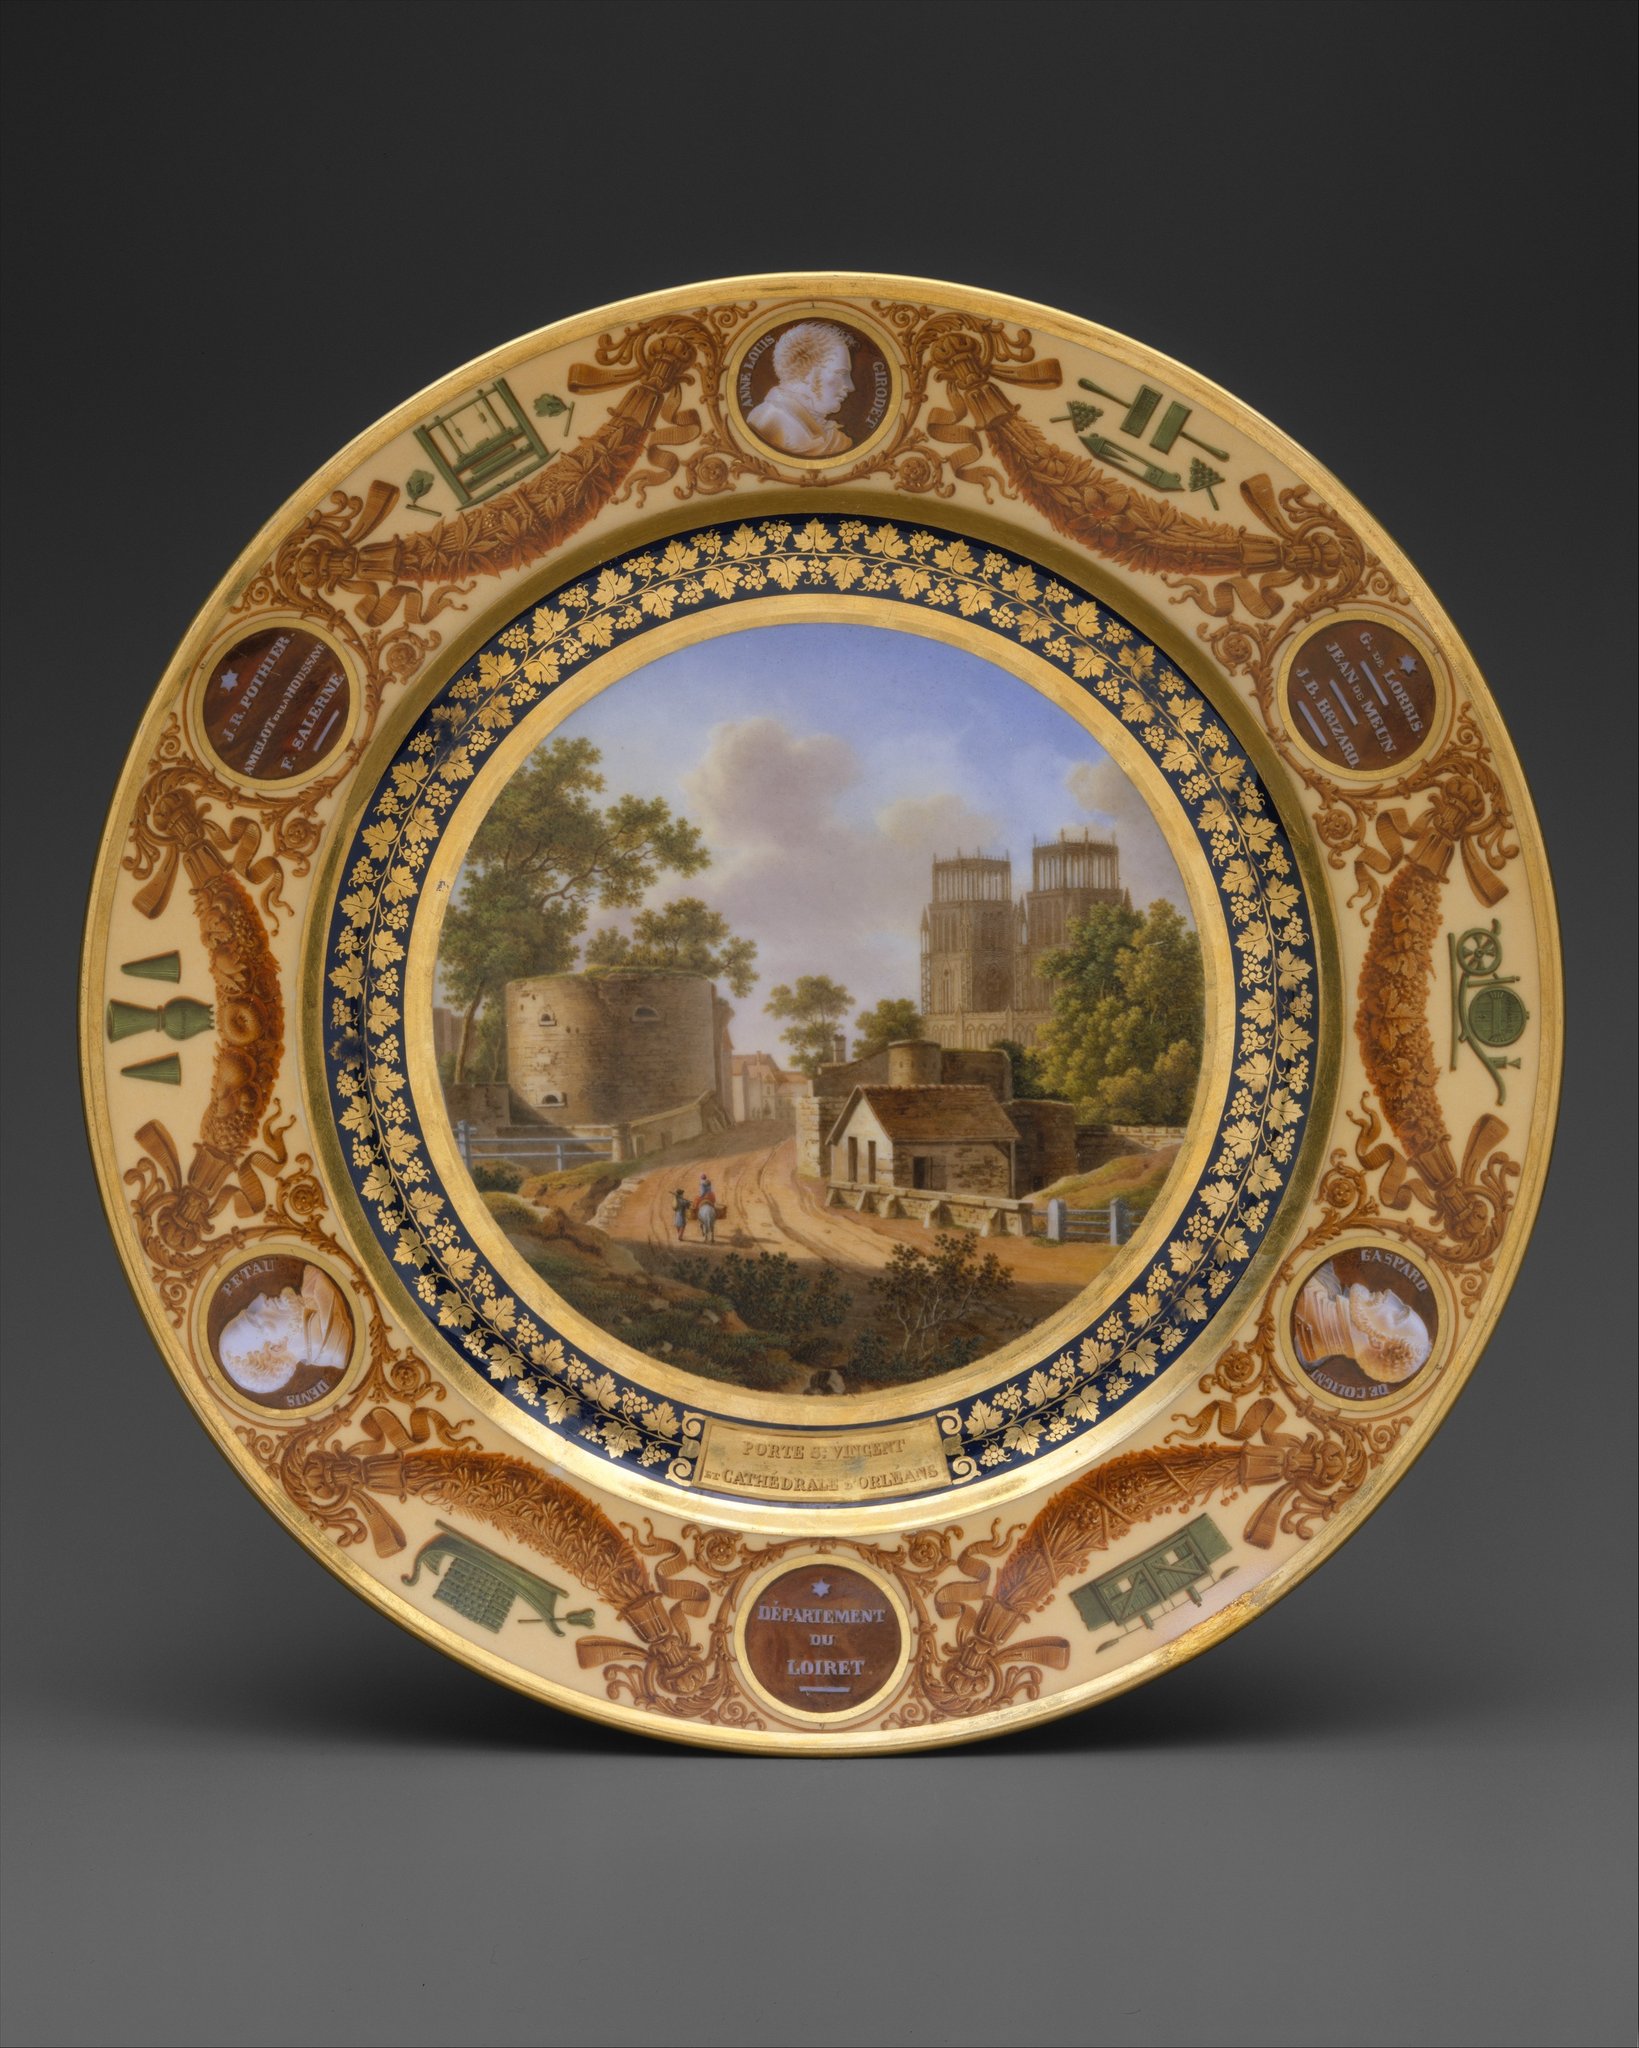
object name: plate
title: Plate from the "Service Des Départements"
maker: sèvres manufactory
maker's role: manufactory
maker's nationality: french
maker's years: 1740-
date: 1827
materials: hard paste porcelain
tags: cathedrals